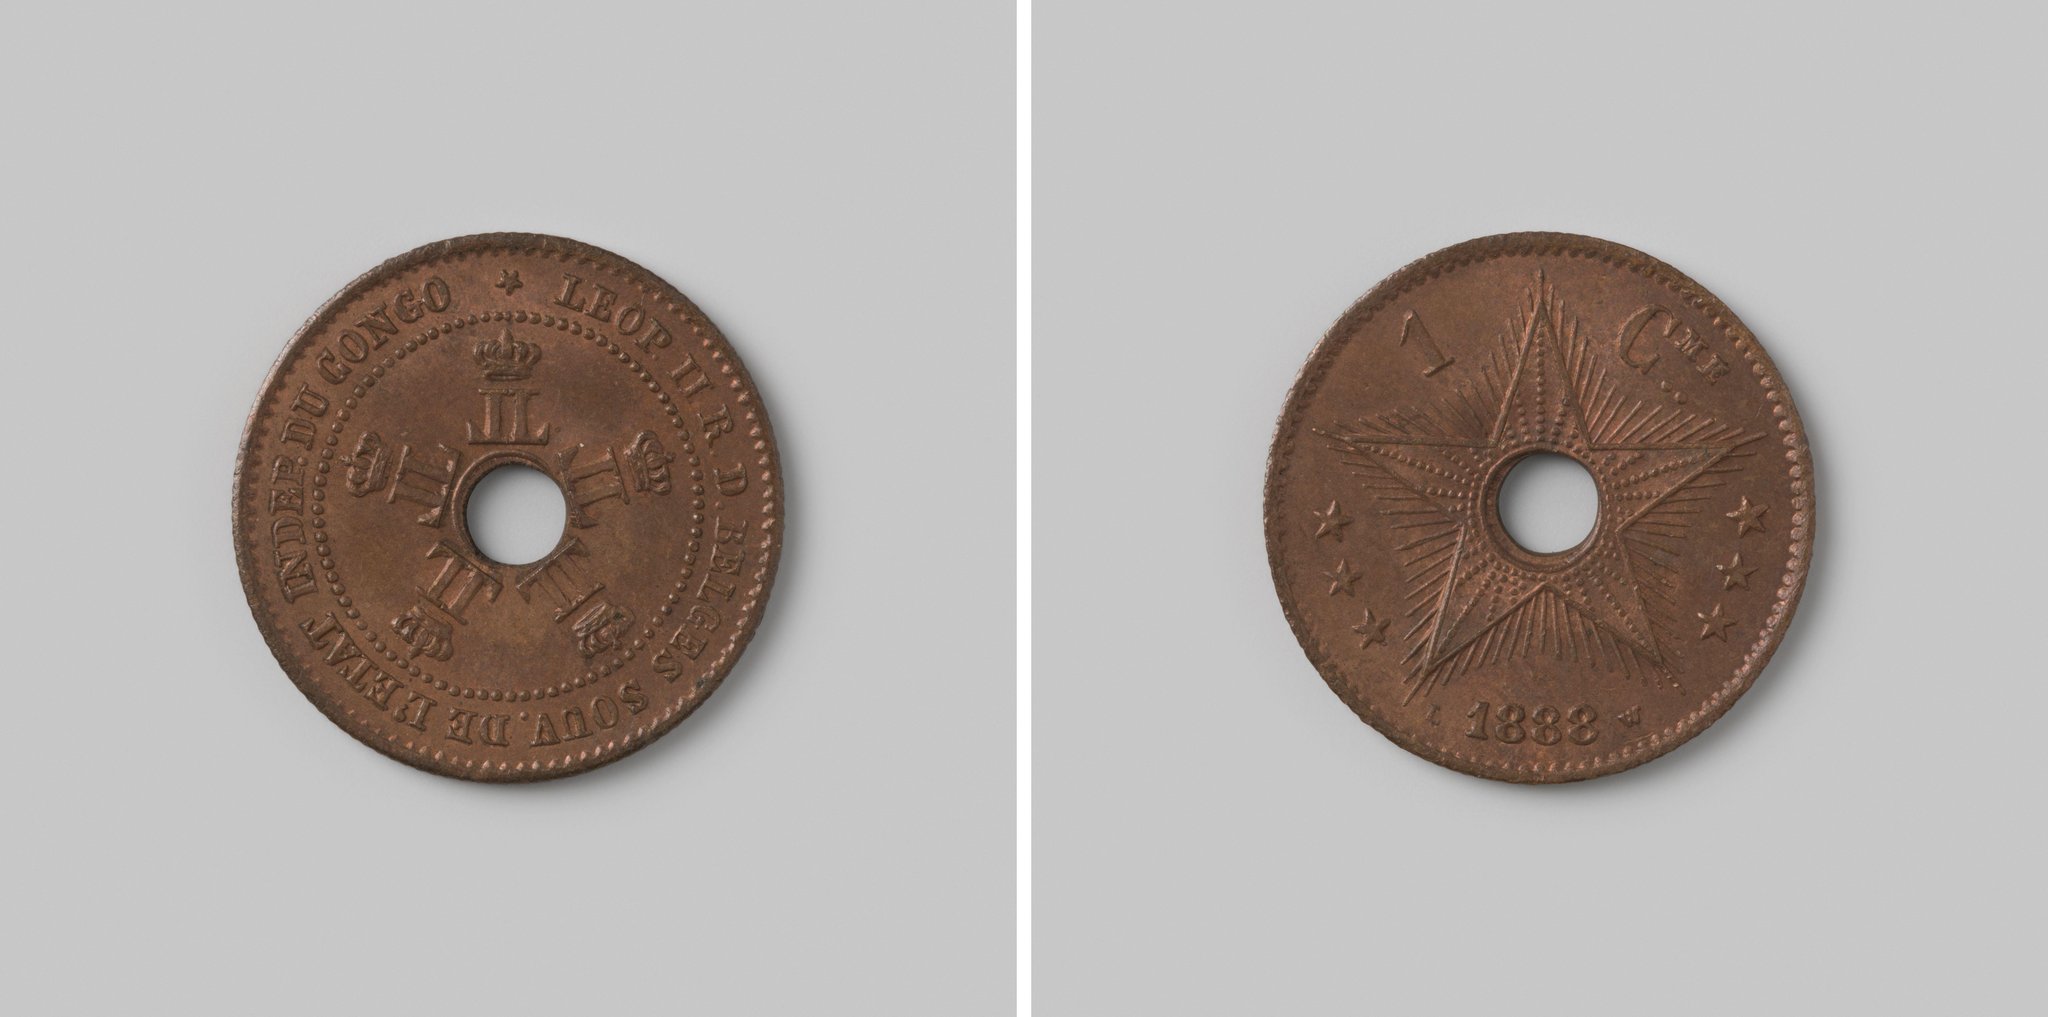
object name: coin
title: Congo Vrijstaat, koning Leopold II van België als soeverein, centime, 1888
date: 1888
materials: copper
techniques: striking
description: Koperen munt met centrale doorboring. Voorzijde: rondom centrale doorboring vijf, in vijfpuntige stervorm geplaatste dubbele, ten opzichte van elkaar gespiegelde, letters L, waarboven een kroon [= koning Leopold II]. Keerzijde: rondom centrale doorboring vijfpuntige ster, waaruit stralen. In omschrift waarde-aanduiding: 1 Cme.. en jaartal. Kartelrand.